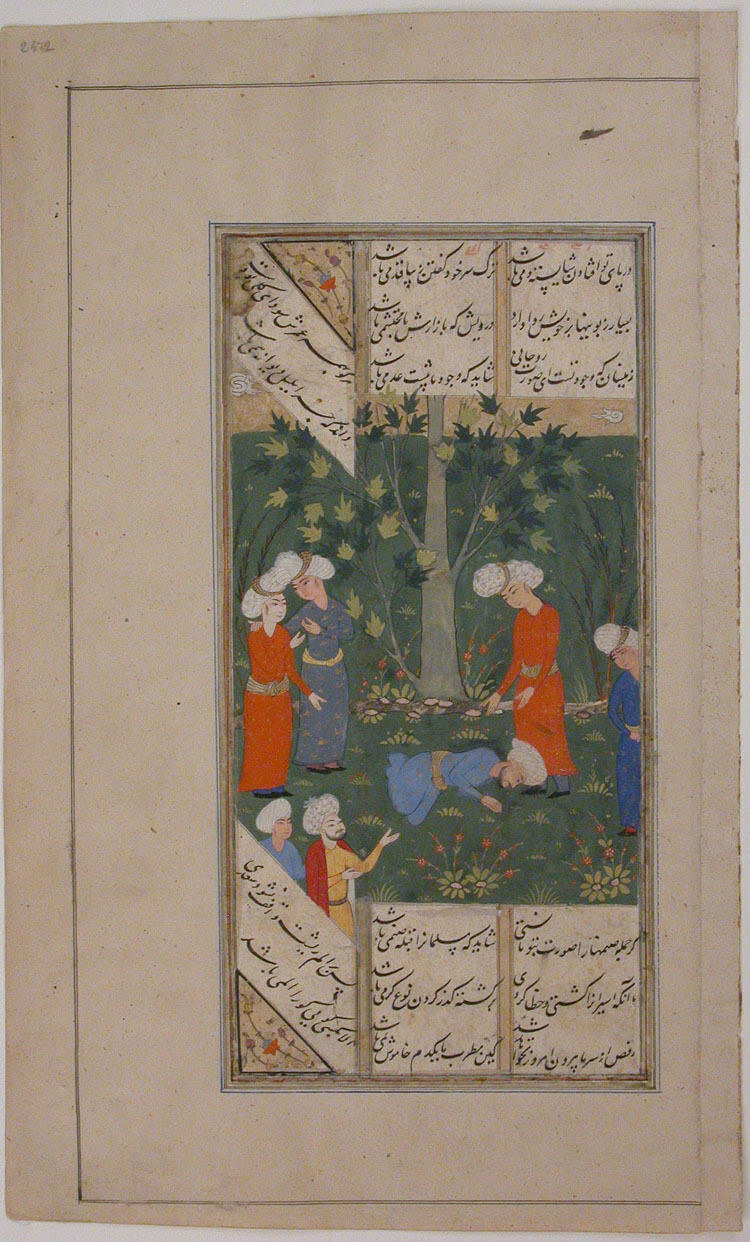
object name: folio from an illustrated manuscript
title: "A Lover Falls Before the Feet of his Beloved", Folio from a Kulliyat (Complete Works) of Sa'di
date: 1801-1900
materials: gold, ink, paper, watercolor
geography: india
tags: men